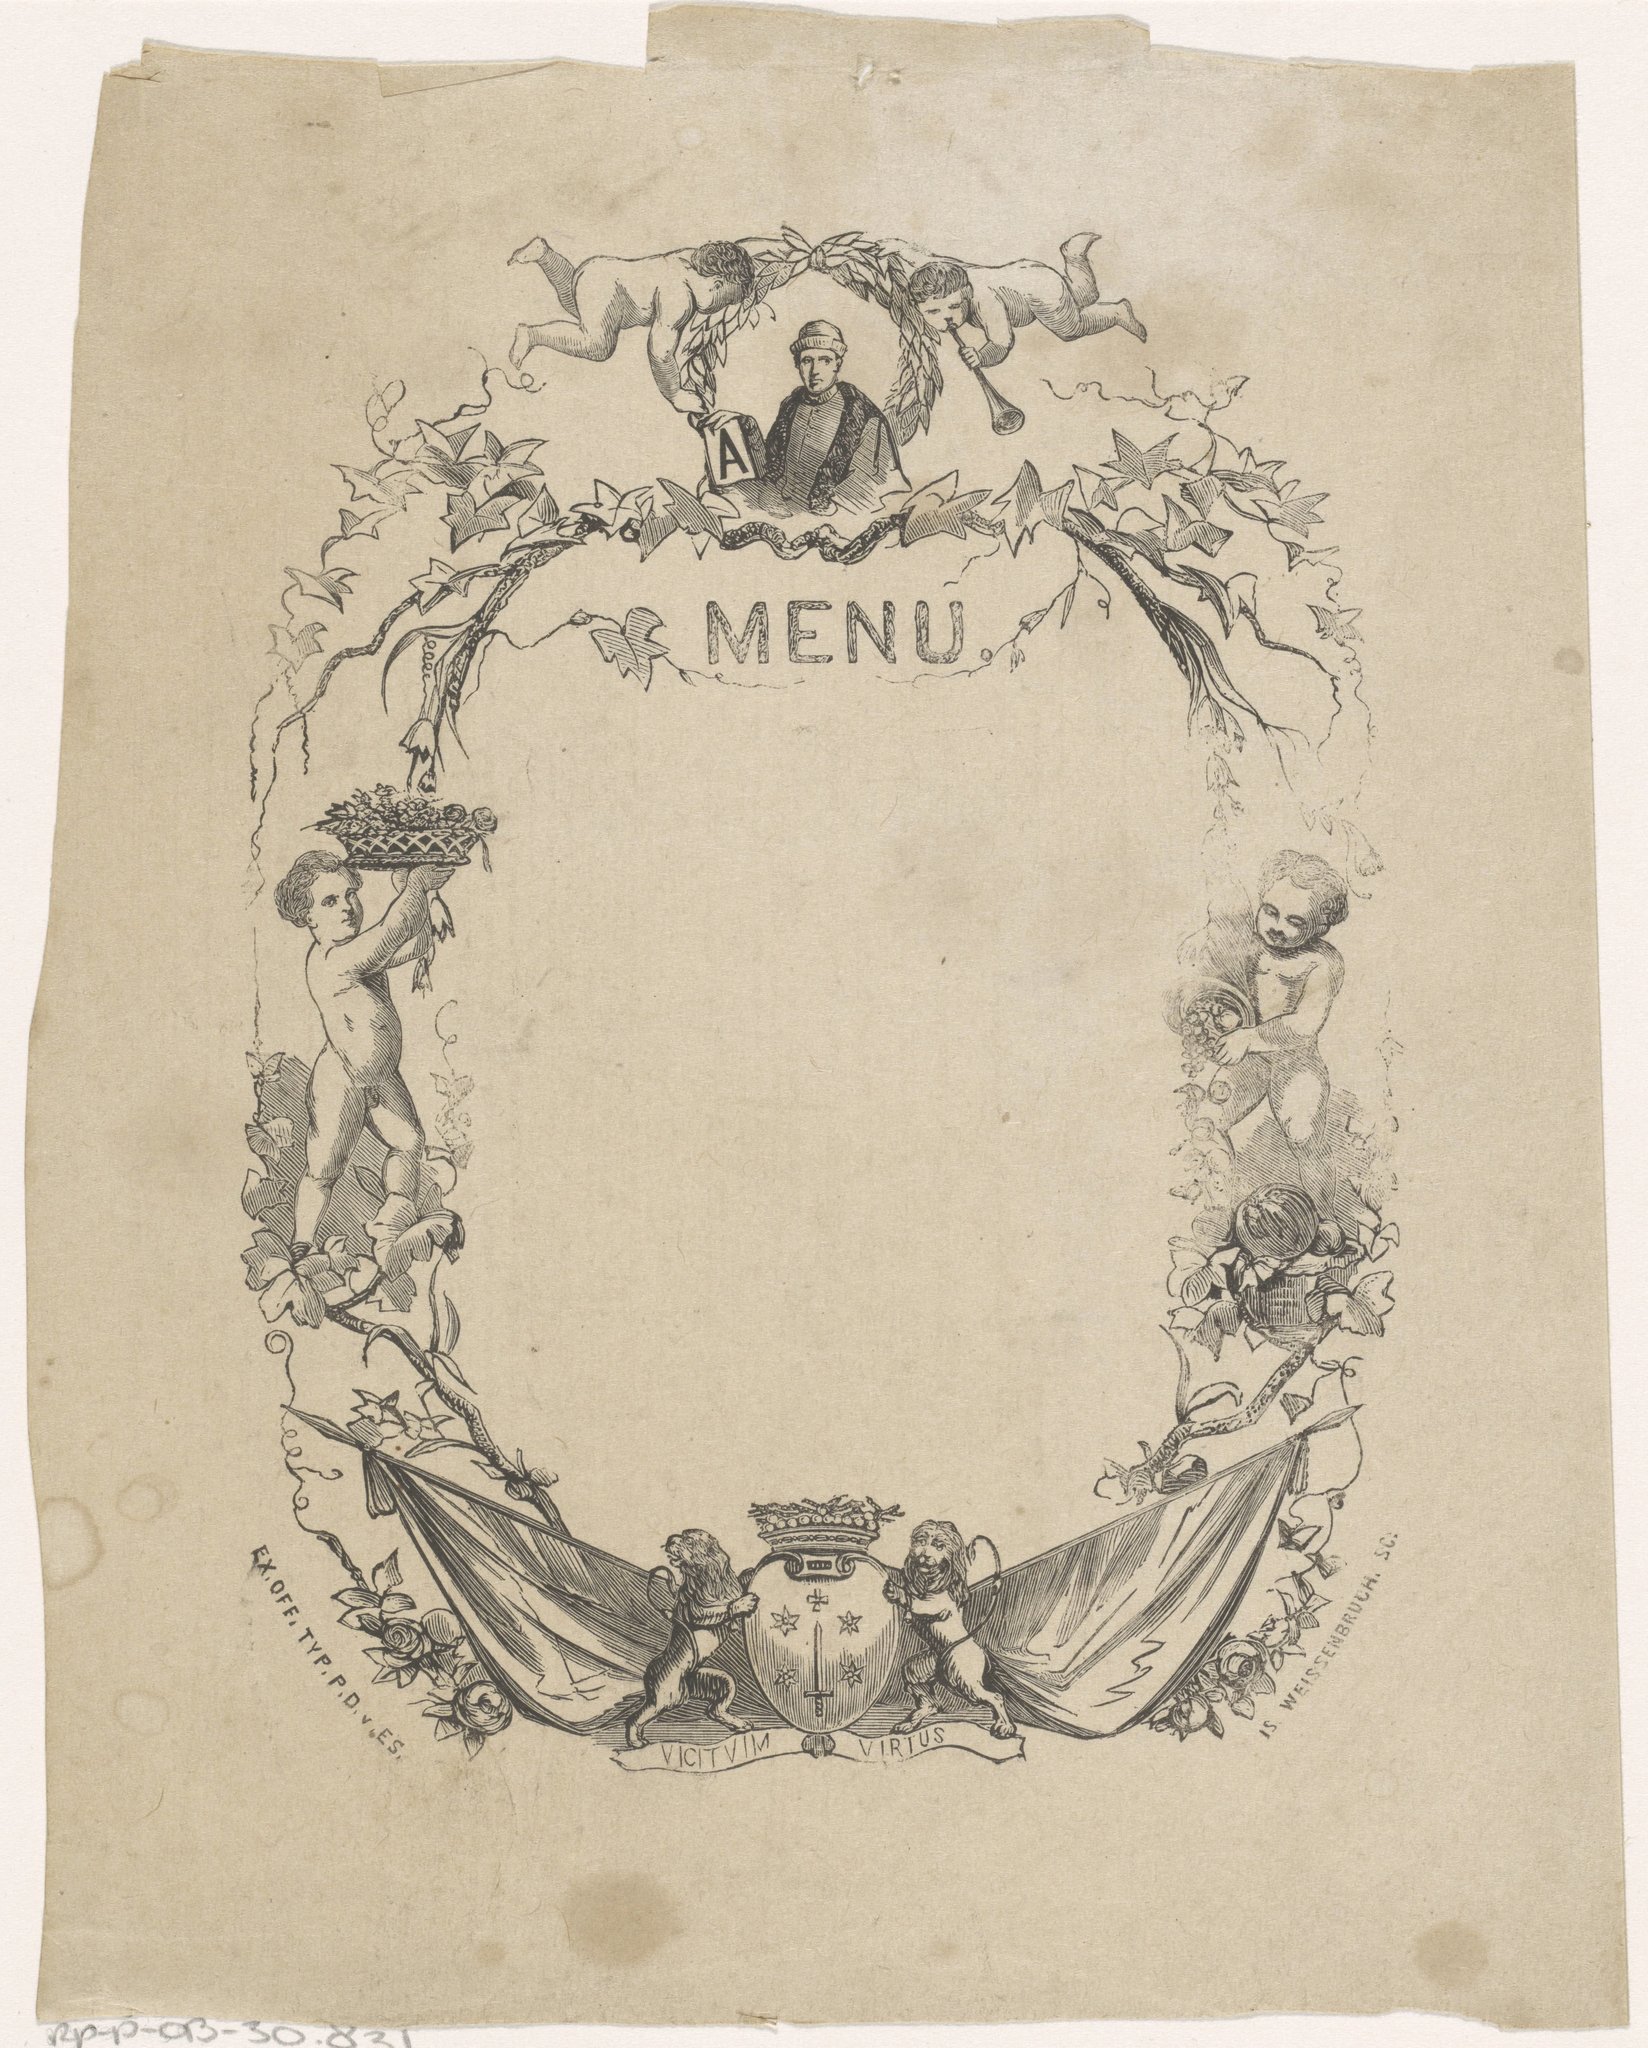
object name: print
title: Geornamenteerde omlijsting voor een menu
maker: isaac weissenbruch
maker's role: print maker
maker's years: 1826-1912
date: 1851-1857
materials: paper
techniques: engraving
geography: amsterdam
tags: haarlem, plants (in general), coat of arms (as symbol of the state, etc.) (+ city; municipal), 'cornucopia', horn of plenty, cupids: 'amores', 'amoretti', 'putti'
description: Midden boven een portret van Laurens Jansz. Coster. Midden onder het wapen van de stad Haarlem met een kroon en twee leeuwen. Daar omheen bloemen, planten en een aantal putti met een lauwerkrans, een bazuin en de hoorn des overvloeds.